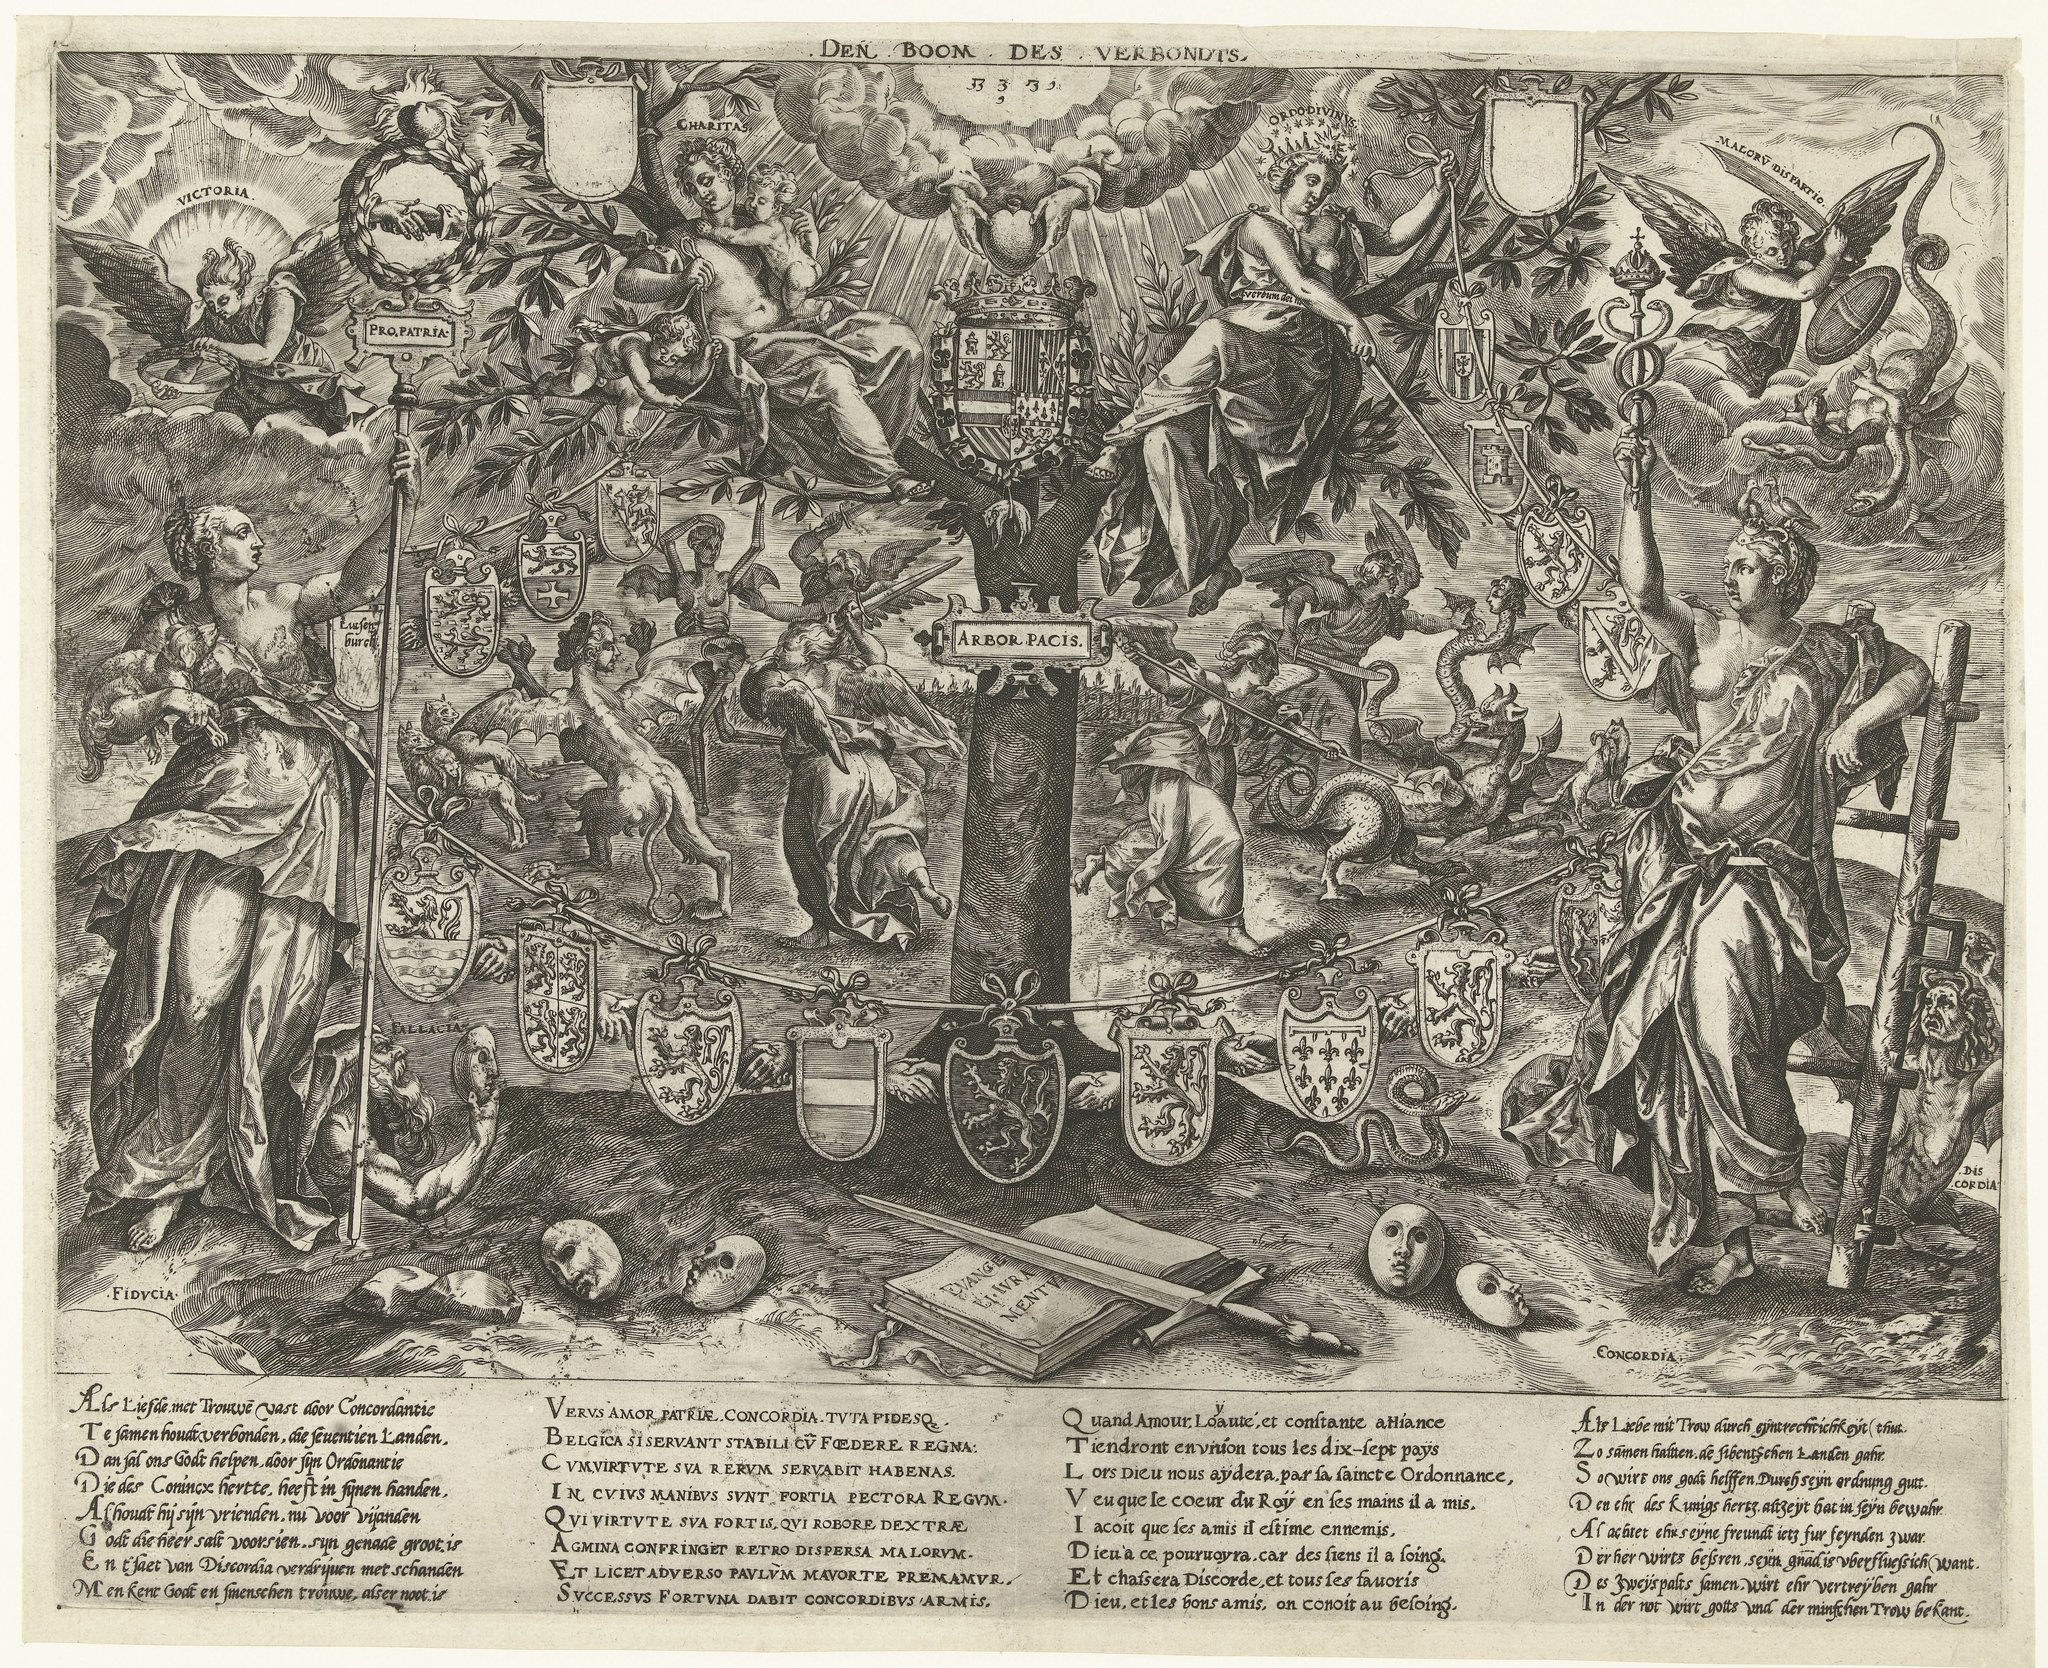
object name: print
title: Den Boom des Verbondts / Arbor Pacis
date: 1578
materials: paper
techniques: engraving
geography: southern netherlands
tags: philip ii of spain, agreement, unity; 'concordia', 'concordia insuperabile', 'concordia militare', 'concordia di pace', 'unione civile' (ripa), charity, 'caritas'; 'carità' (ripa) ~ one of the three theological virtues, fidelity; 'fedeltà' (ripa), disagreement, discord; 'discordia' (ripa), delusion, fallacy; 'prima impressione' (ripa), trees (+ plants used symbolically)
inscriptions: inscription: ‘DEN BOOM DES VERBONDTS.’, inscription: ‘ARBOR.PACIS.’, caption: ‘Als Liefde met Trouwe vast door Concordantie....In der not wirt gotts und der Minschen trou bekant.’